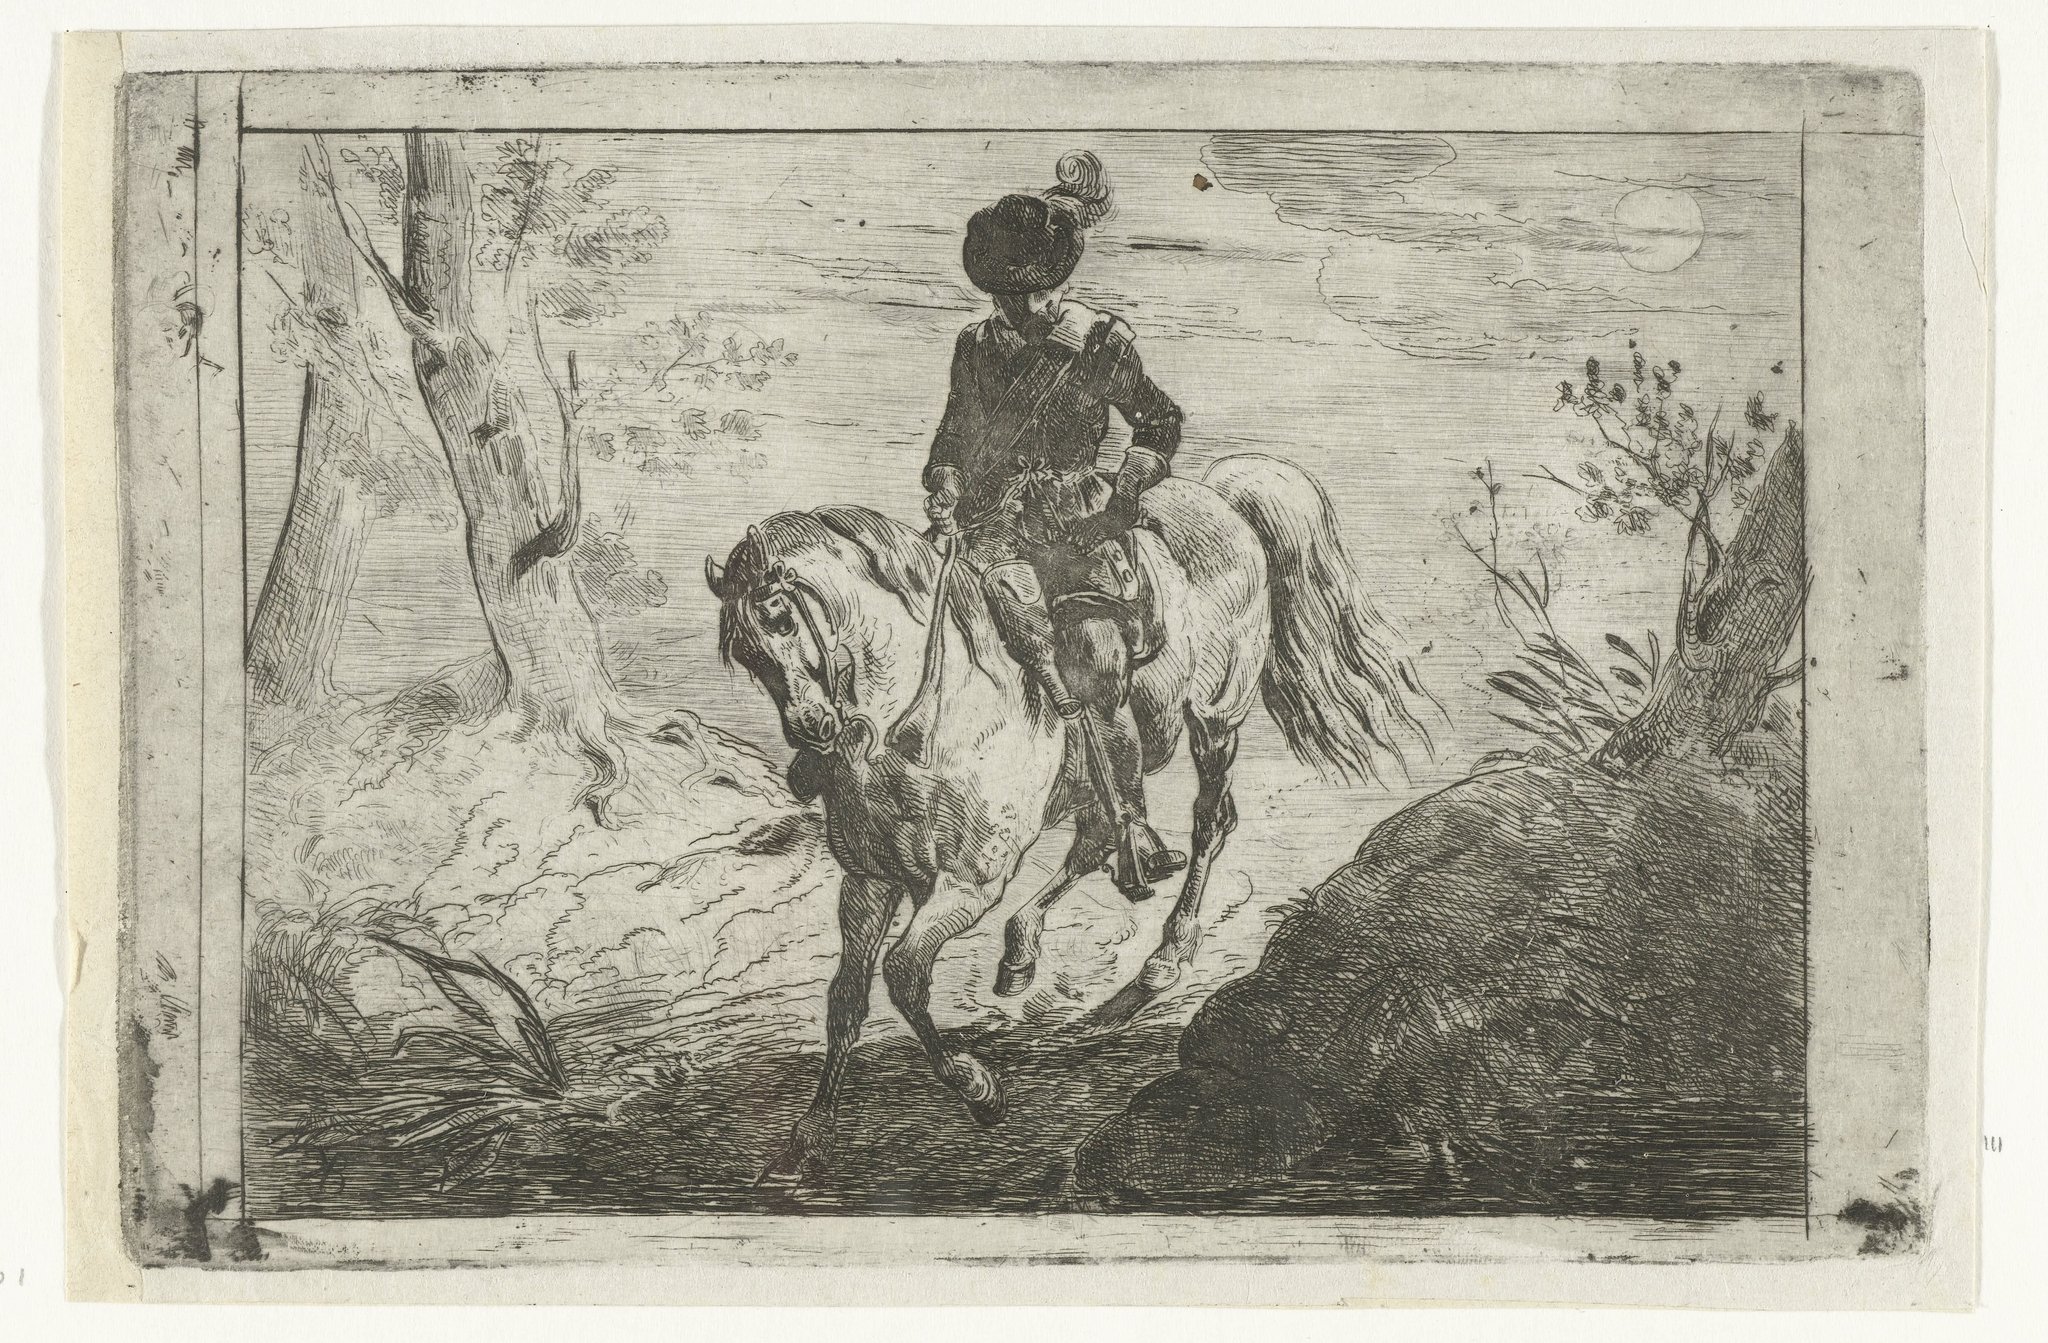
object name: print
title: Ruiter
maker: karel frederik bombled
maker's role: draughtsman, print maker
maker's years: 1822-1902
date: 1832-1902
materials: paper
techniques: drypoint, etching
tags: riding a horse, ass, or mule; rider, horseman, forest path or lane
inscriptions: collector's mark: Lugt 2228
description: Een man te paard rijdt over een weg in het bos. Het is volle maan.